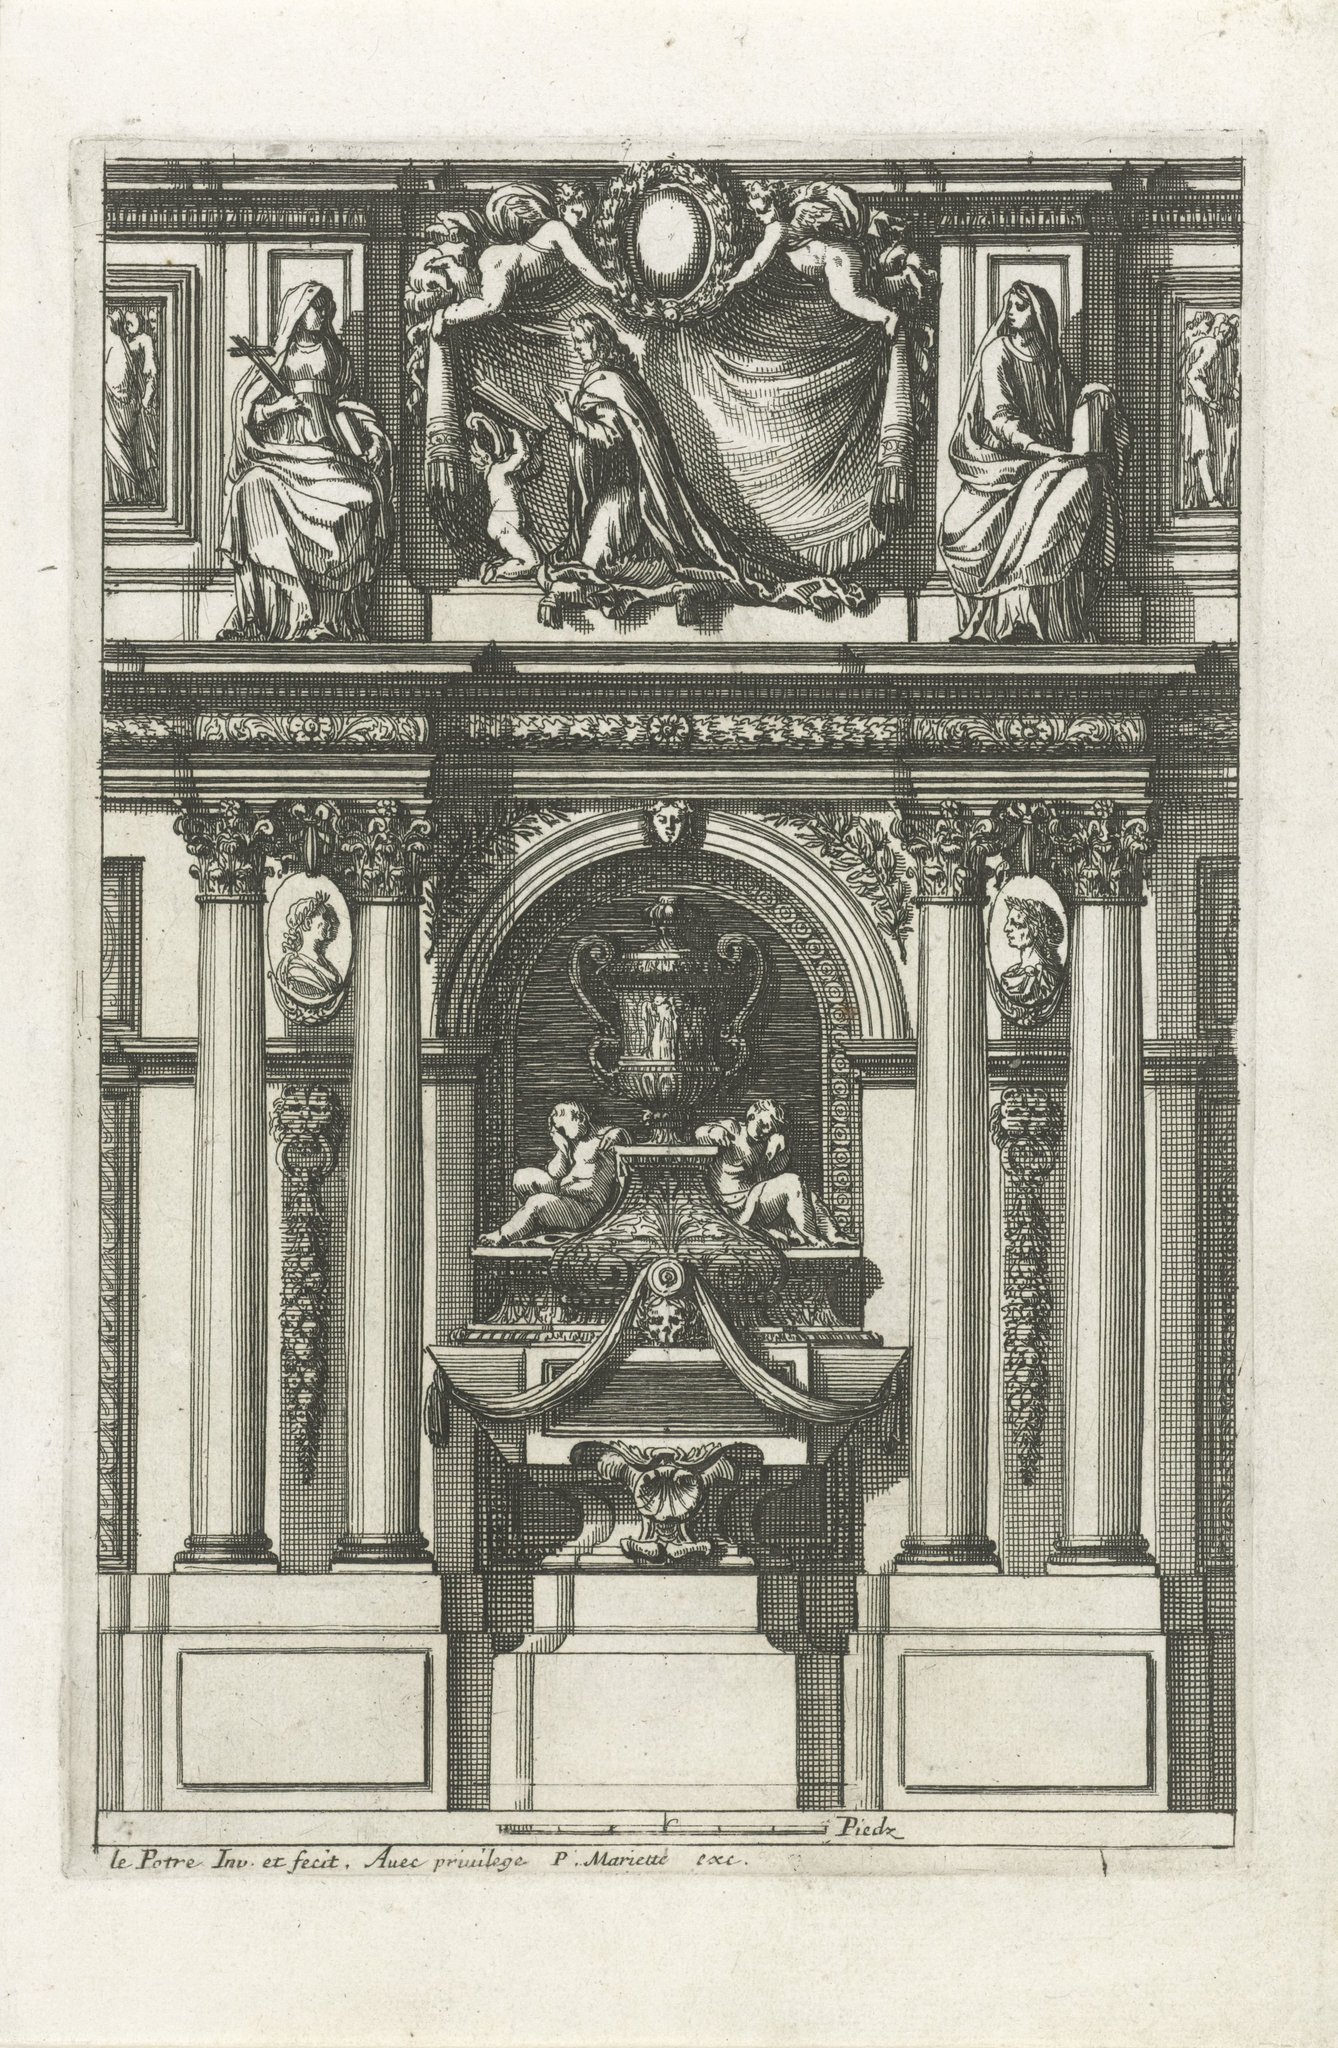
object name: ornament print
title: Grafmonument bekroond met urn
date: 1661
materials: paper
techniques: etching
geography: paris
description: Het grafmonument staat onder een triomfboog met dubbele Korintische zuilen. Blad 3 uit serie van titelblad en 5 bladen, derde editie.